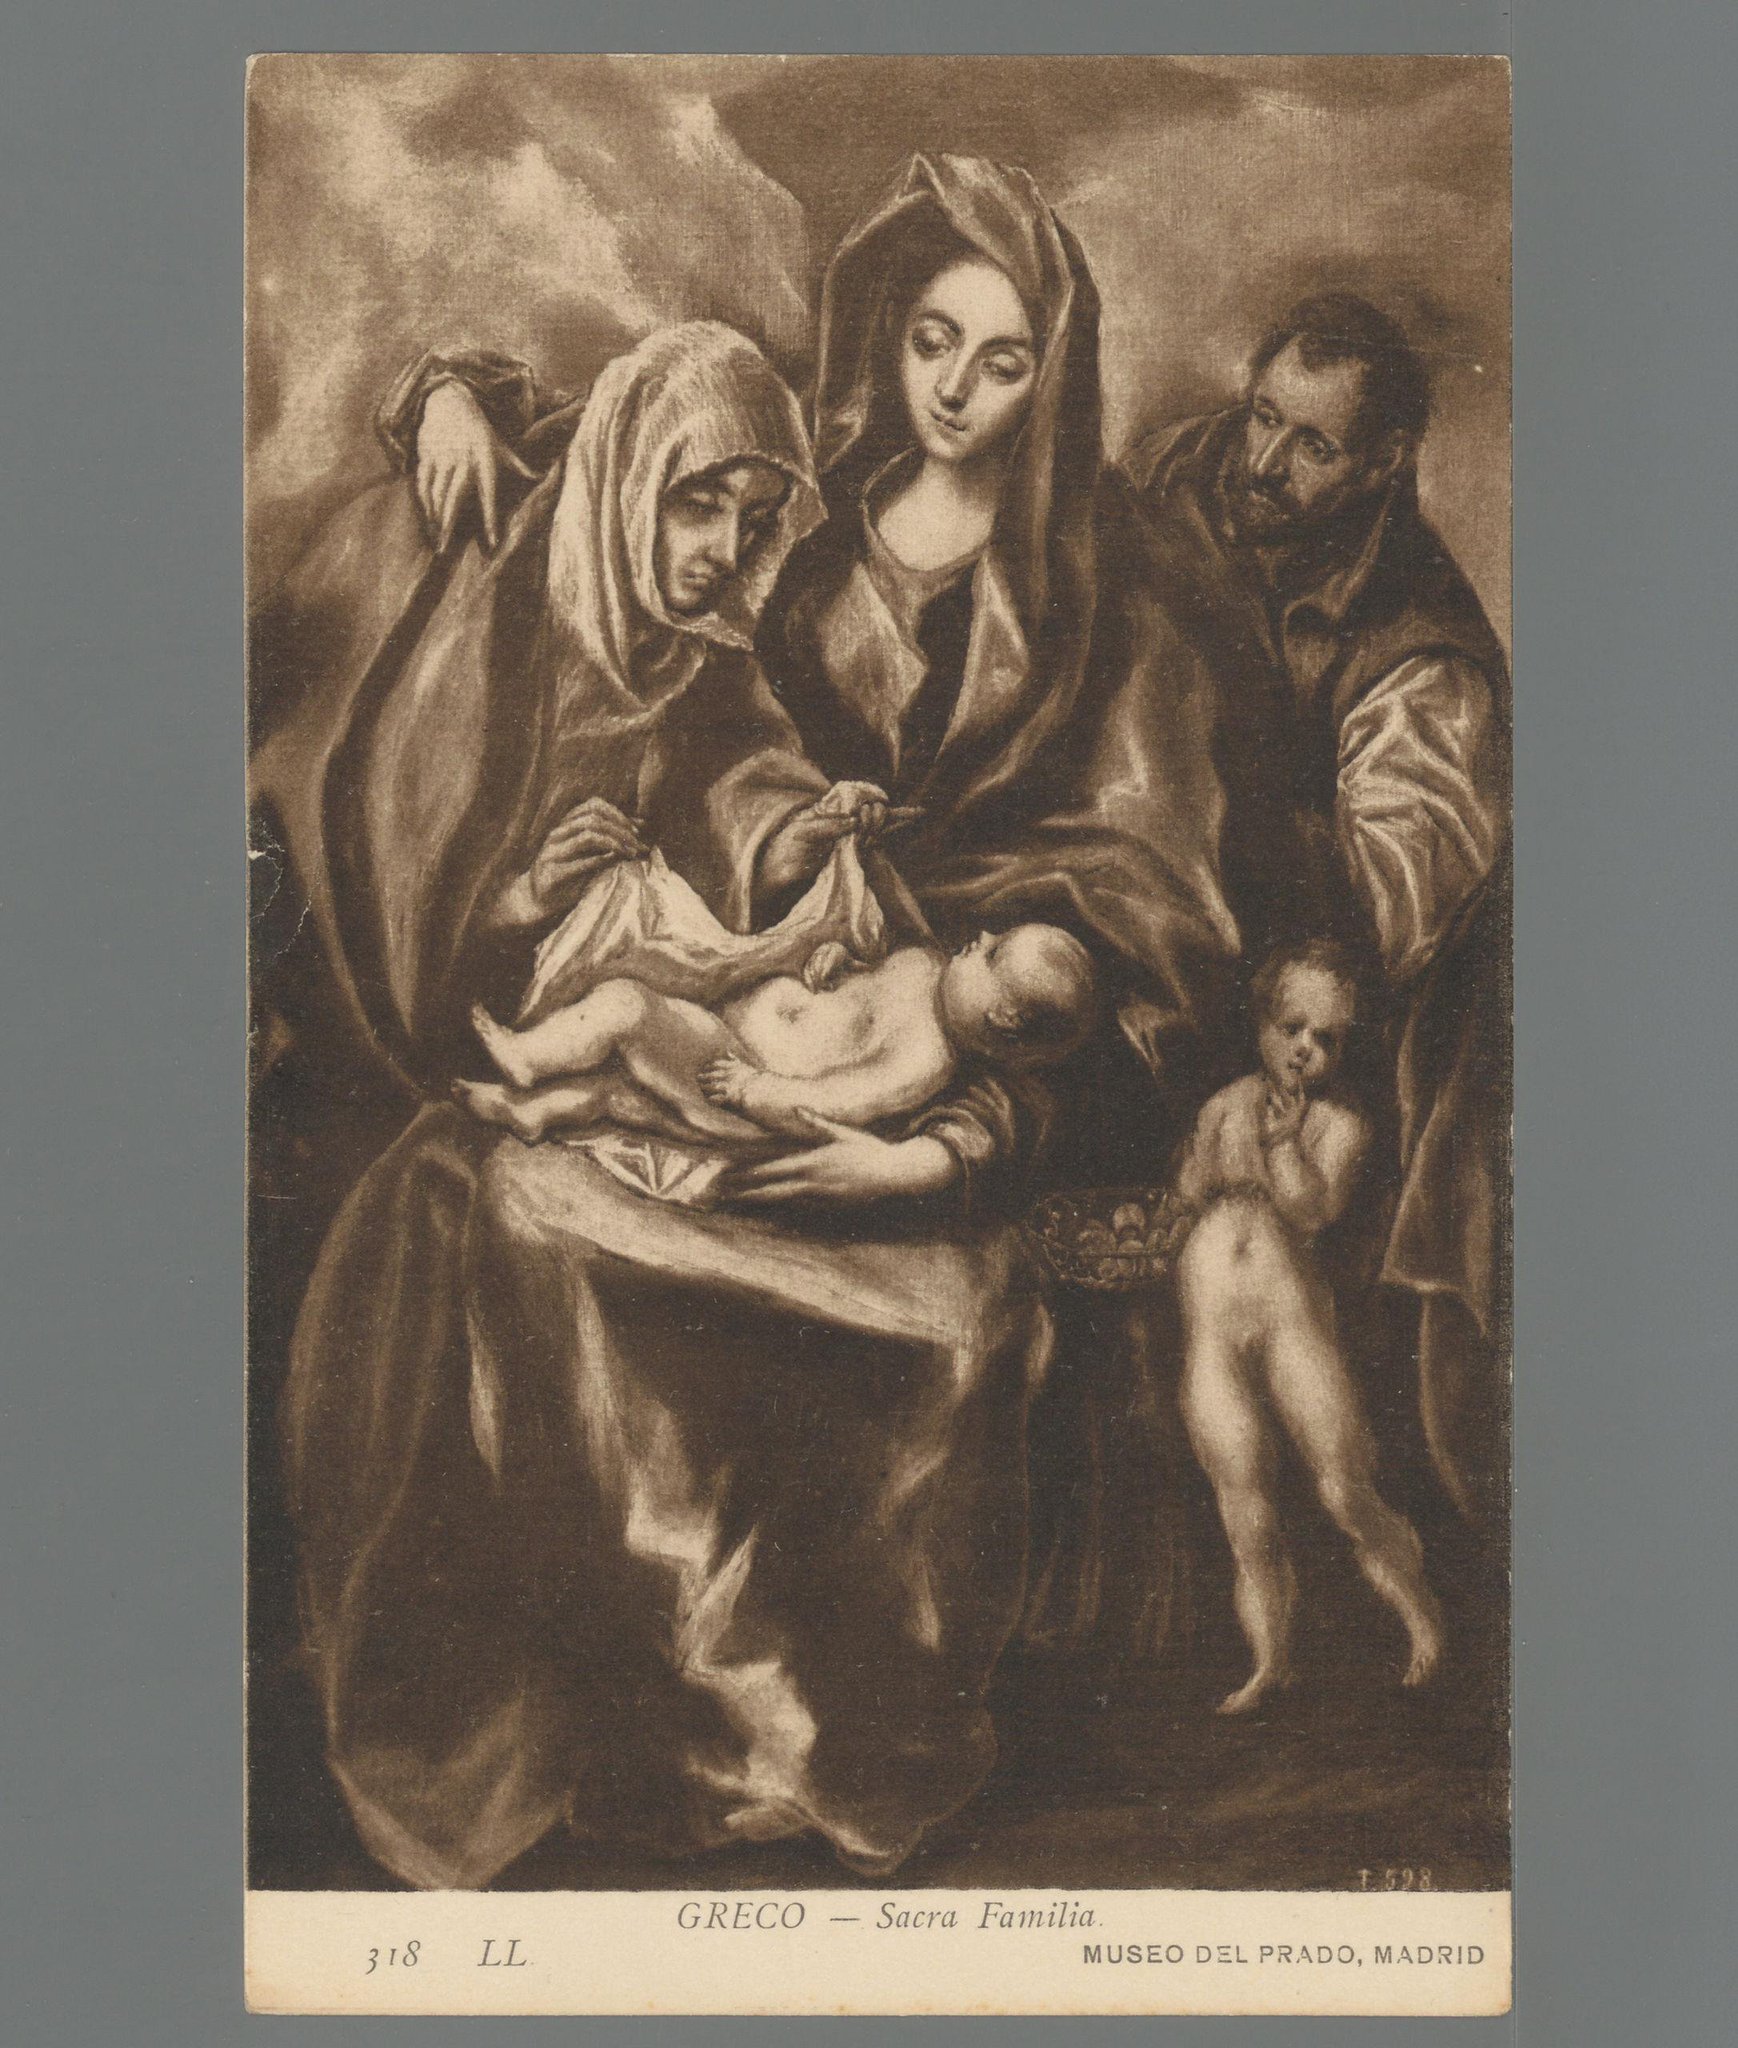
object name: photomechanical print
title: Sacra Familia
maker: el greco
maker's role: draughtsman, painter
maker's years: 1540-1614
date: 1905-1920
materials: cardboard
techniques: photograph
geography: paris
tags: holy family, and derived representations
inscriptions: collector's mark: ‘AFE v S’